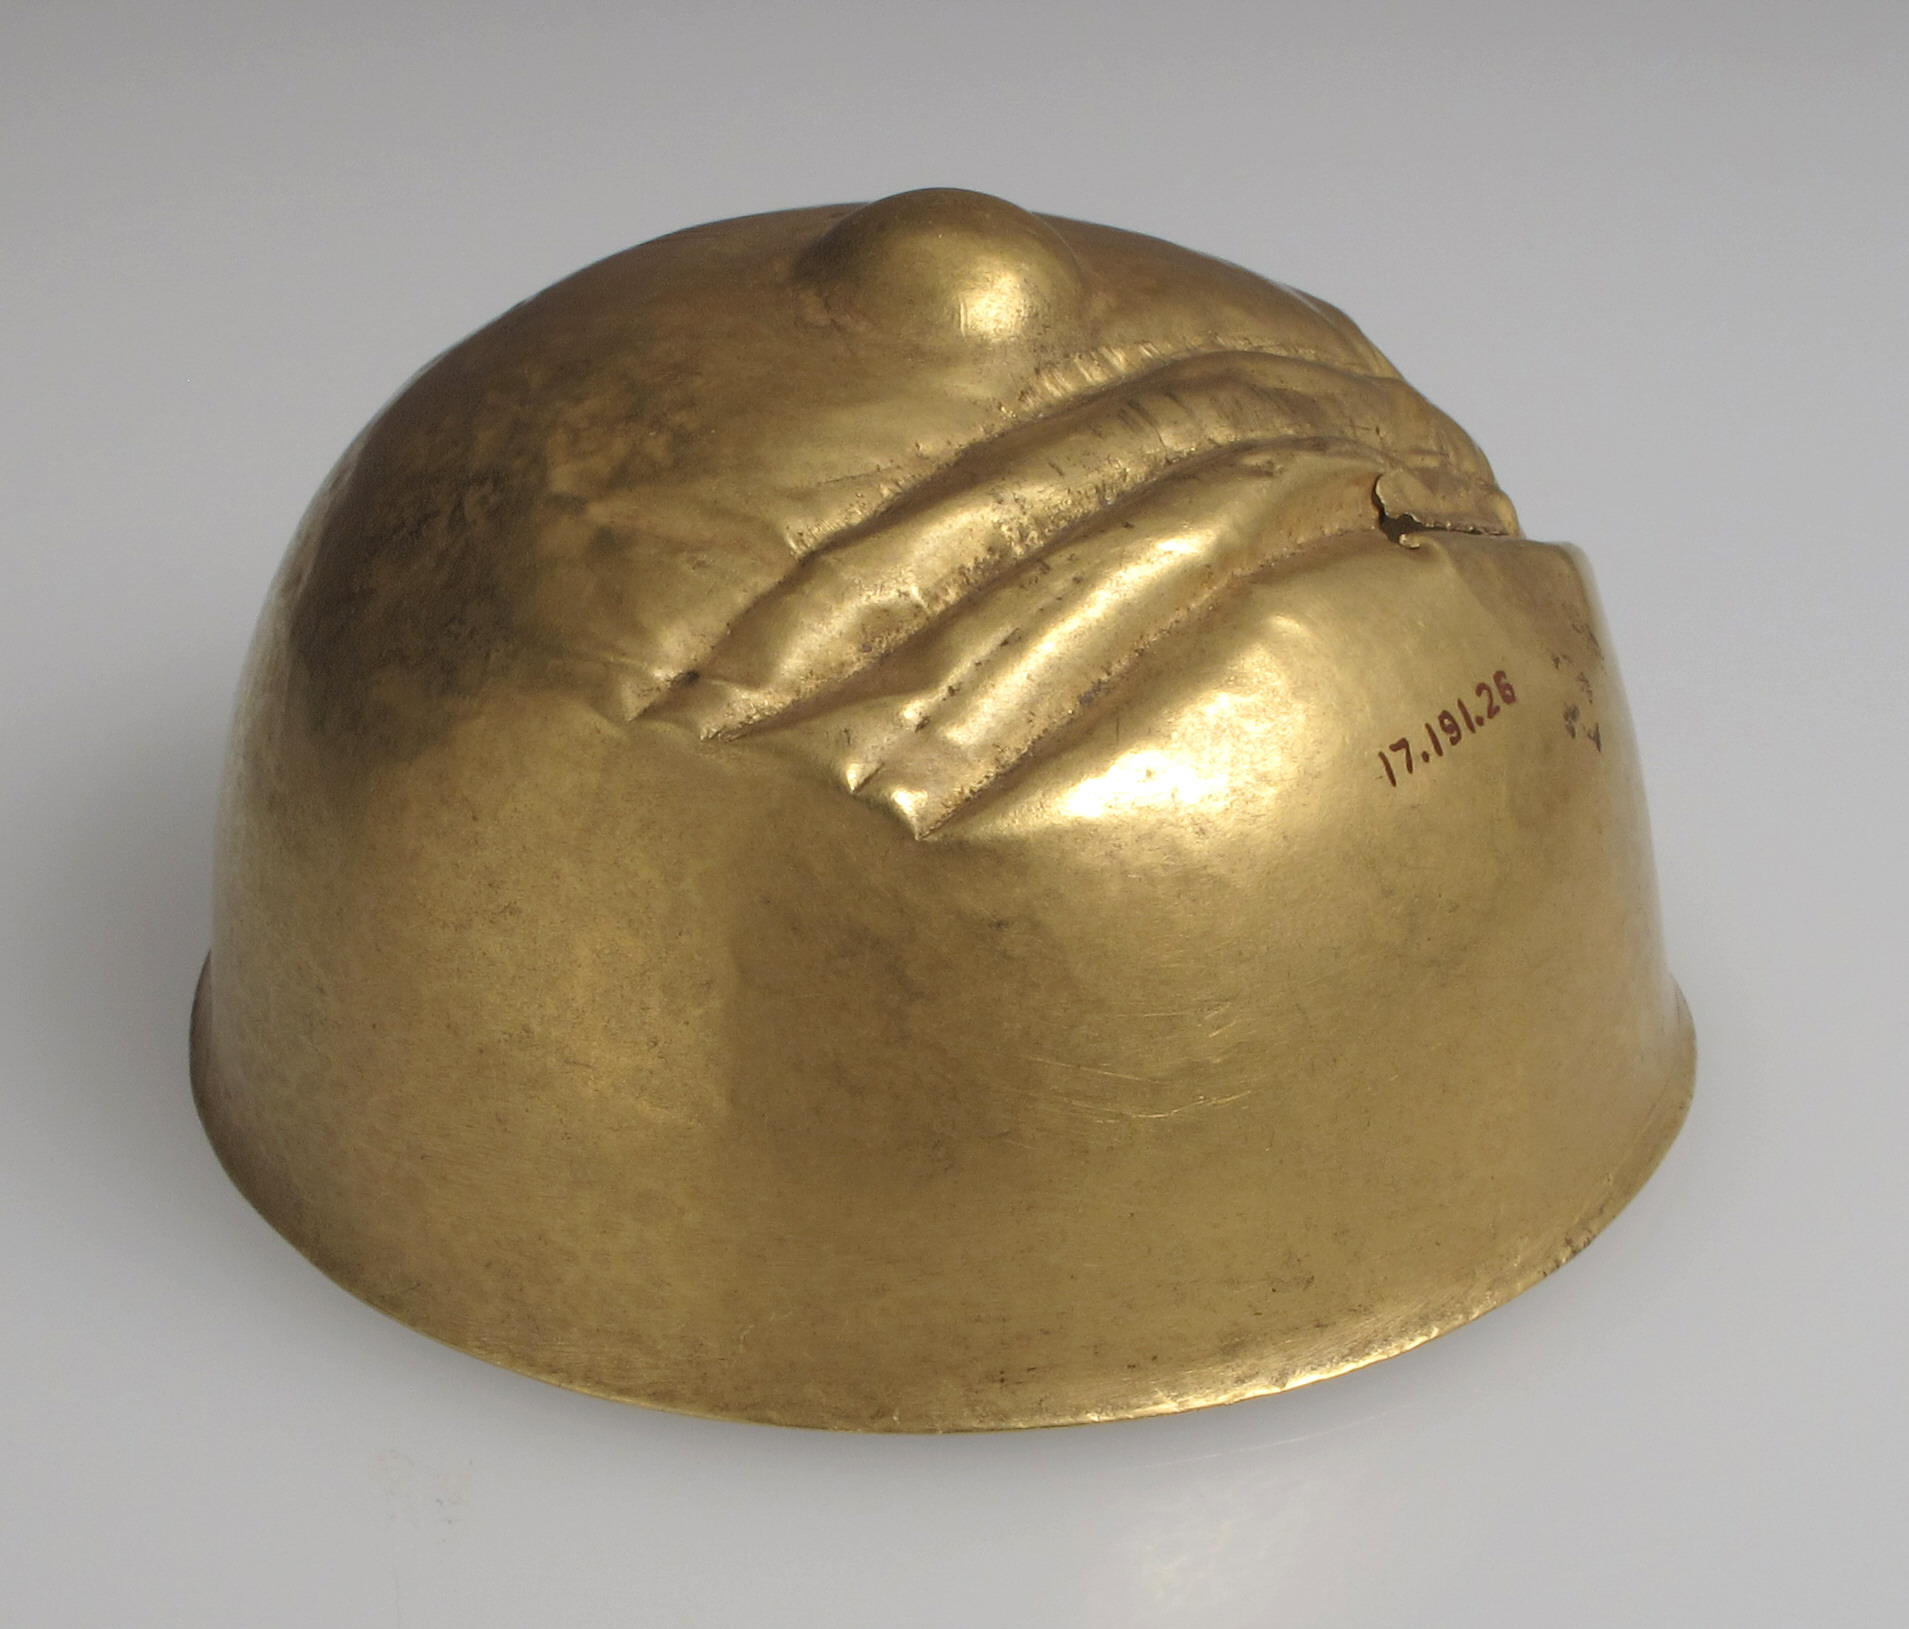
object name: umbo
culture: non-frankish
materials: gold